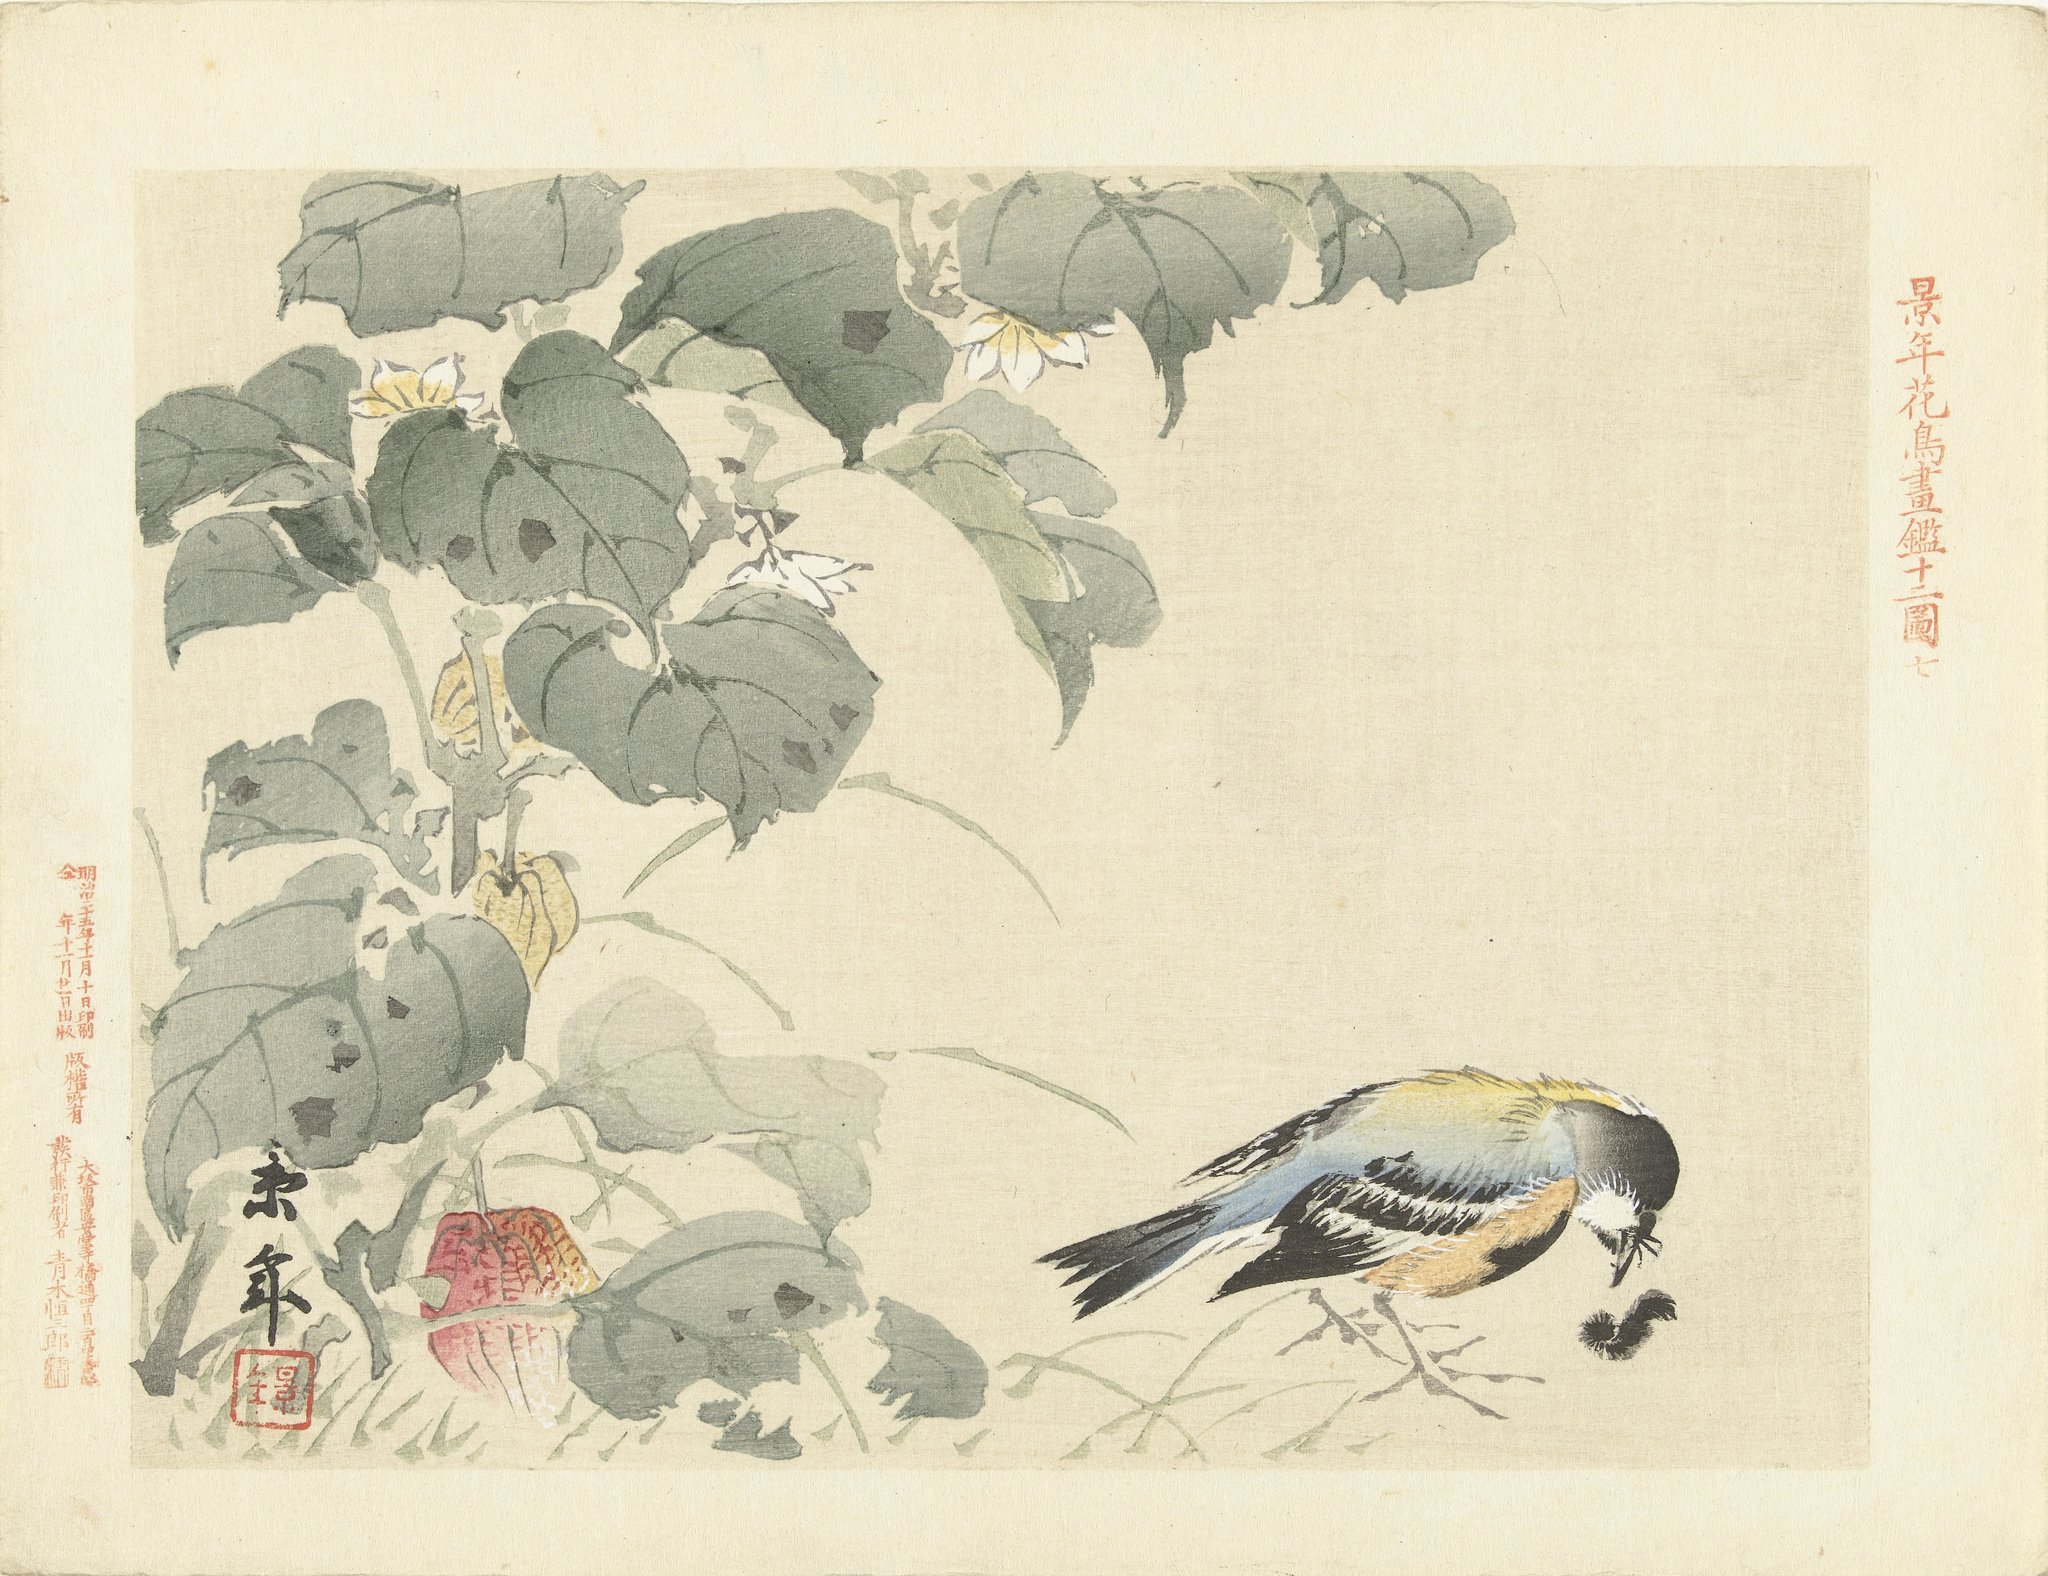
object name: print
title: Bloemen- en vogelschetsen van Keinen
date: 1811-1892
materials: paper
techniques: woodcut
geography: osaka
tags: plants; vegetation, birds, insects: caterpillar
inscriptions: collector's mark: ‘Rijksschool voor kunstnijverheid’ Lugt 3937, collector's mark: Lugt 2228